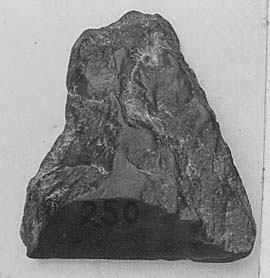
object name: adze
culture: north american, alaskan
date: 1902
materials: jade